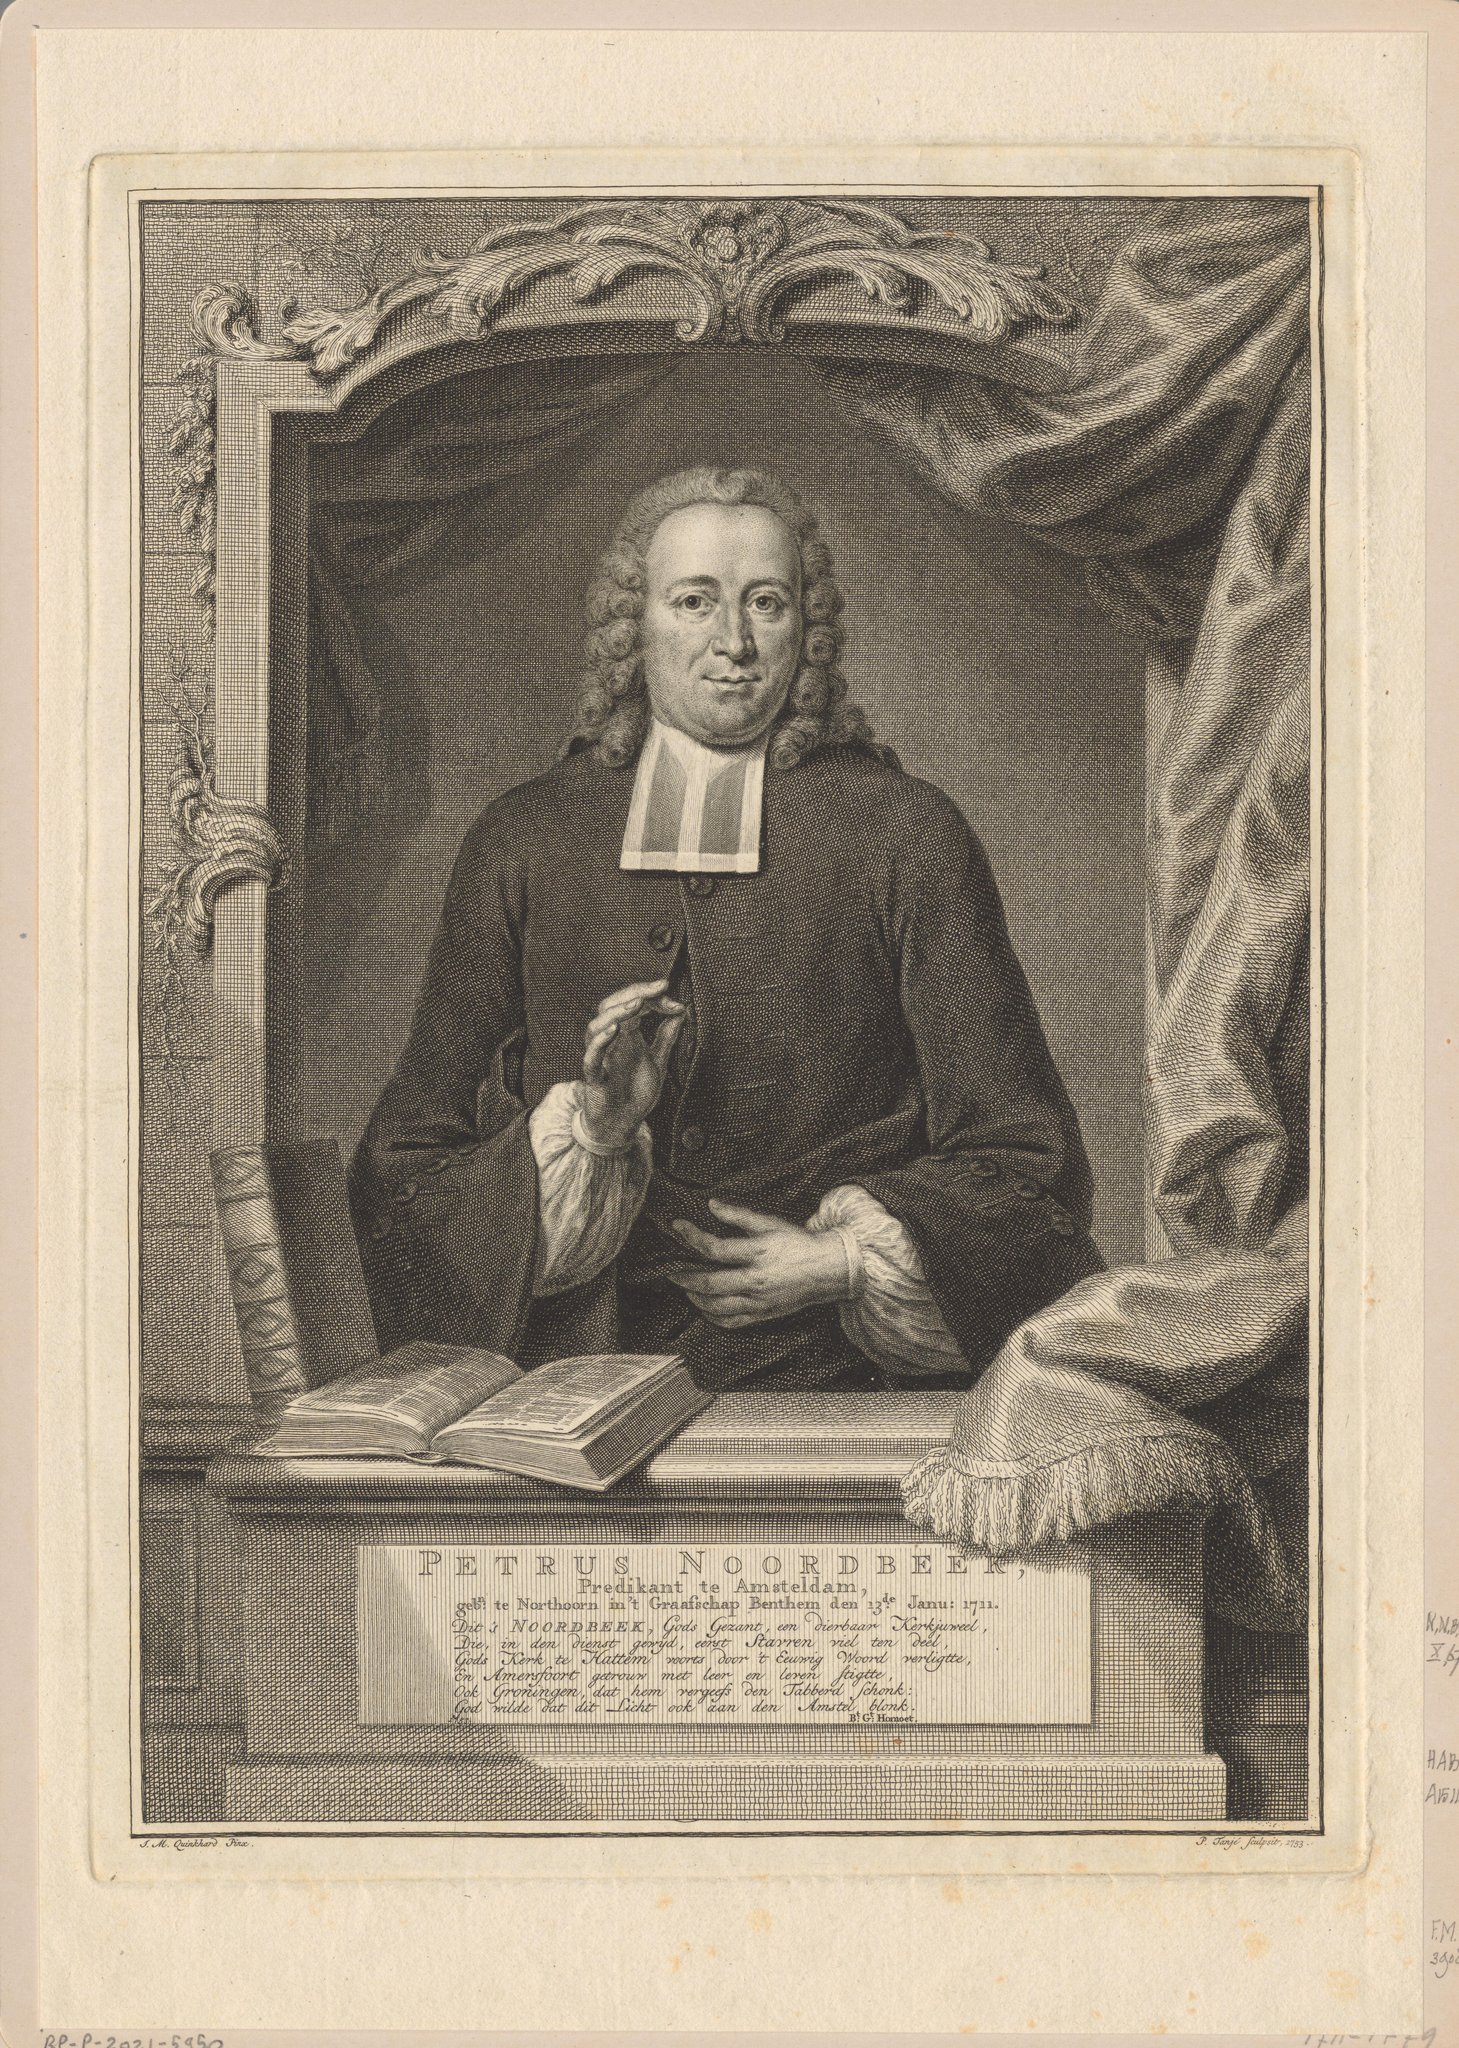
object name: print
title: Portret van Petrus Noordbeek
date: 1753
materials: paper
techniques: engraving, etching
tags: germany, amsterdam, the christian churches, historical persons, book - mm - book open